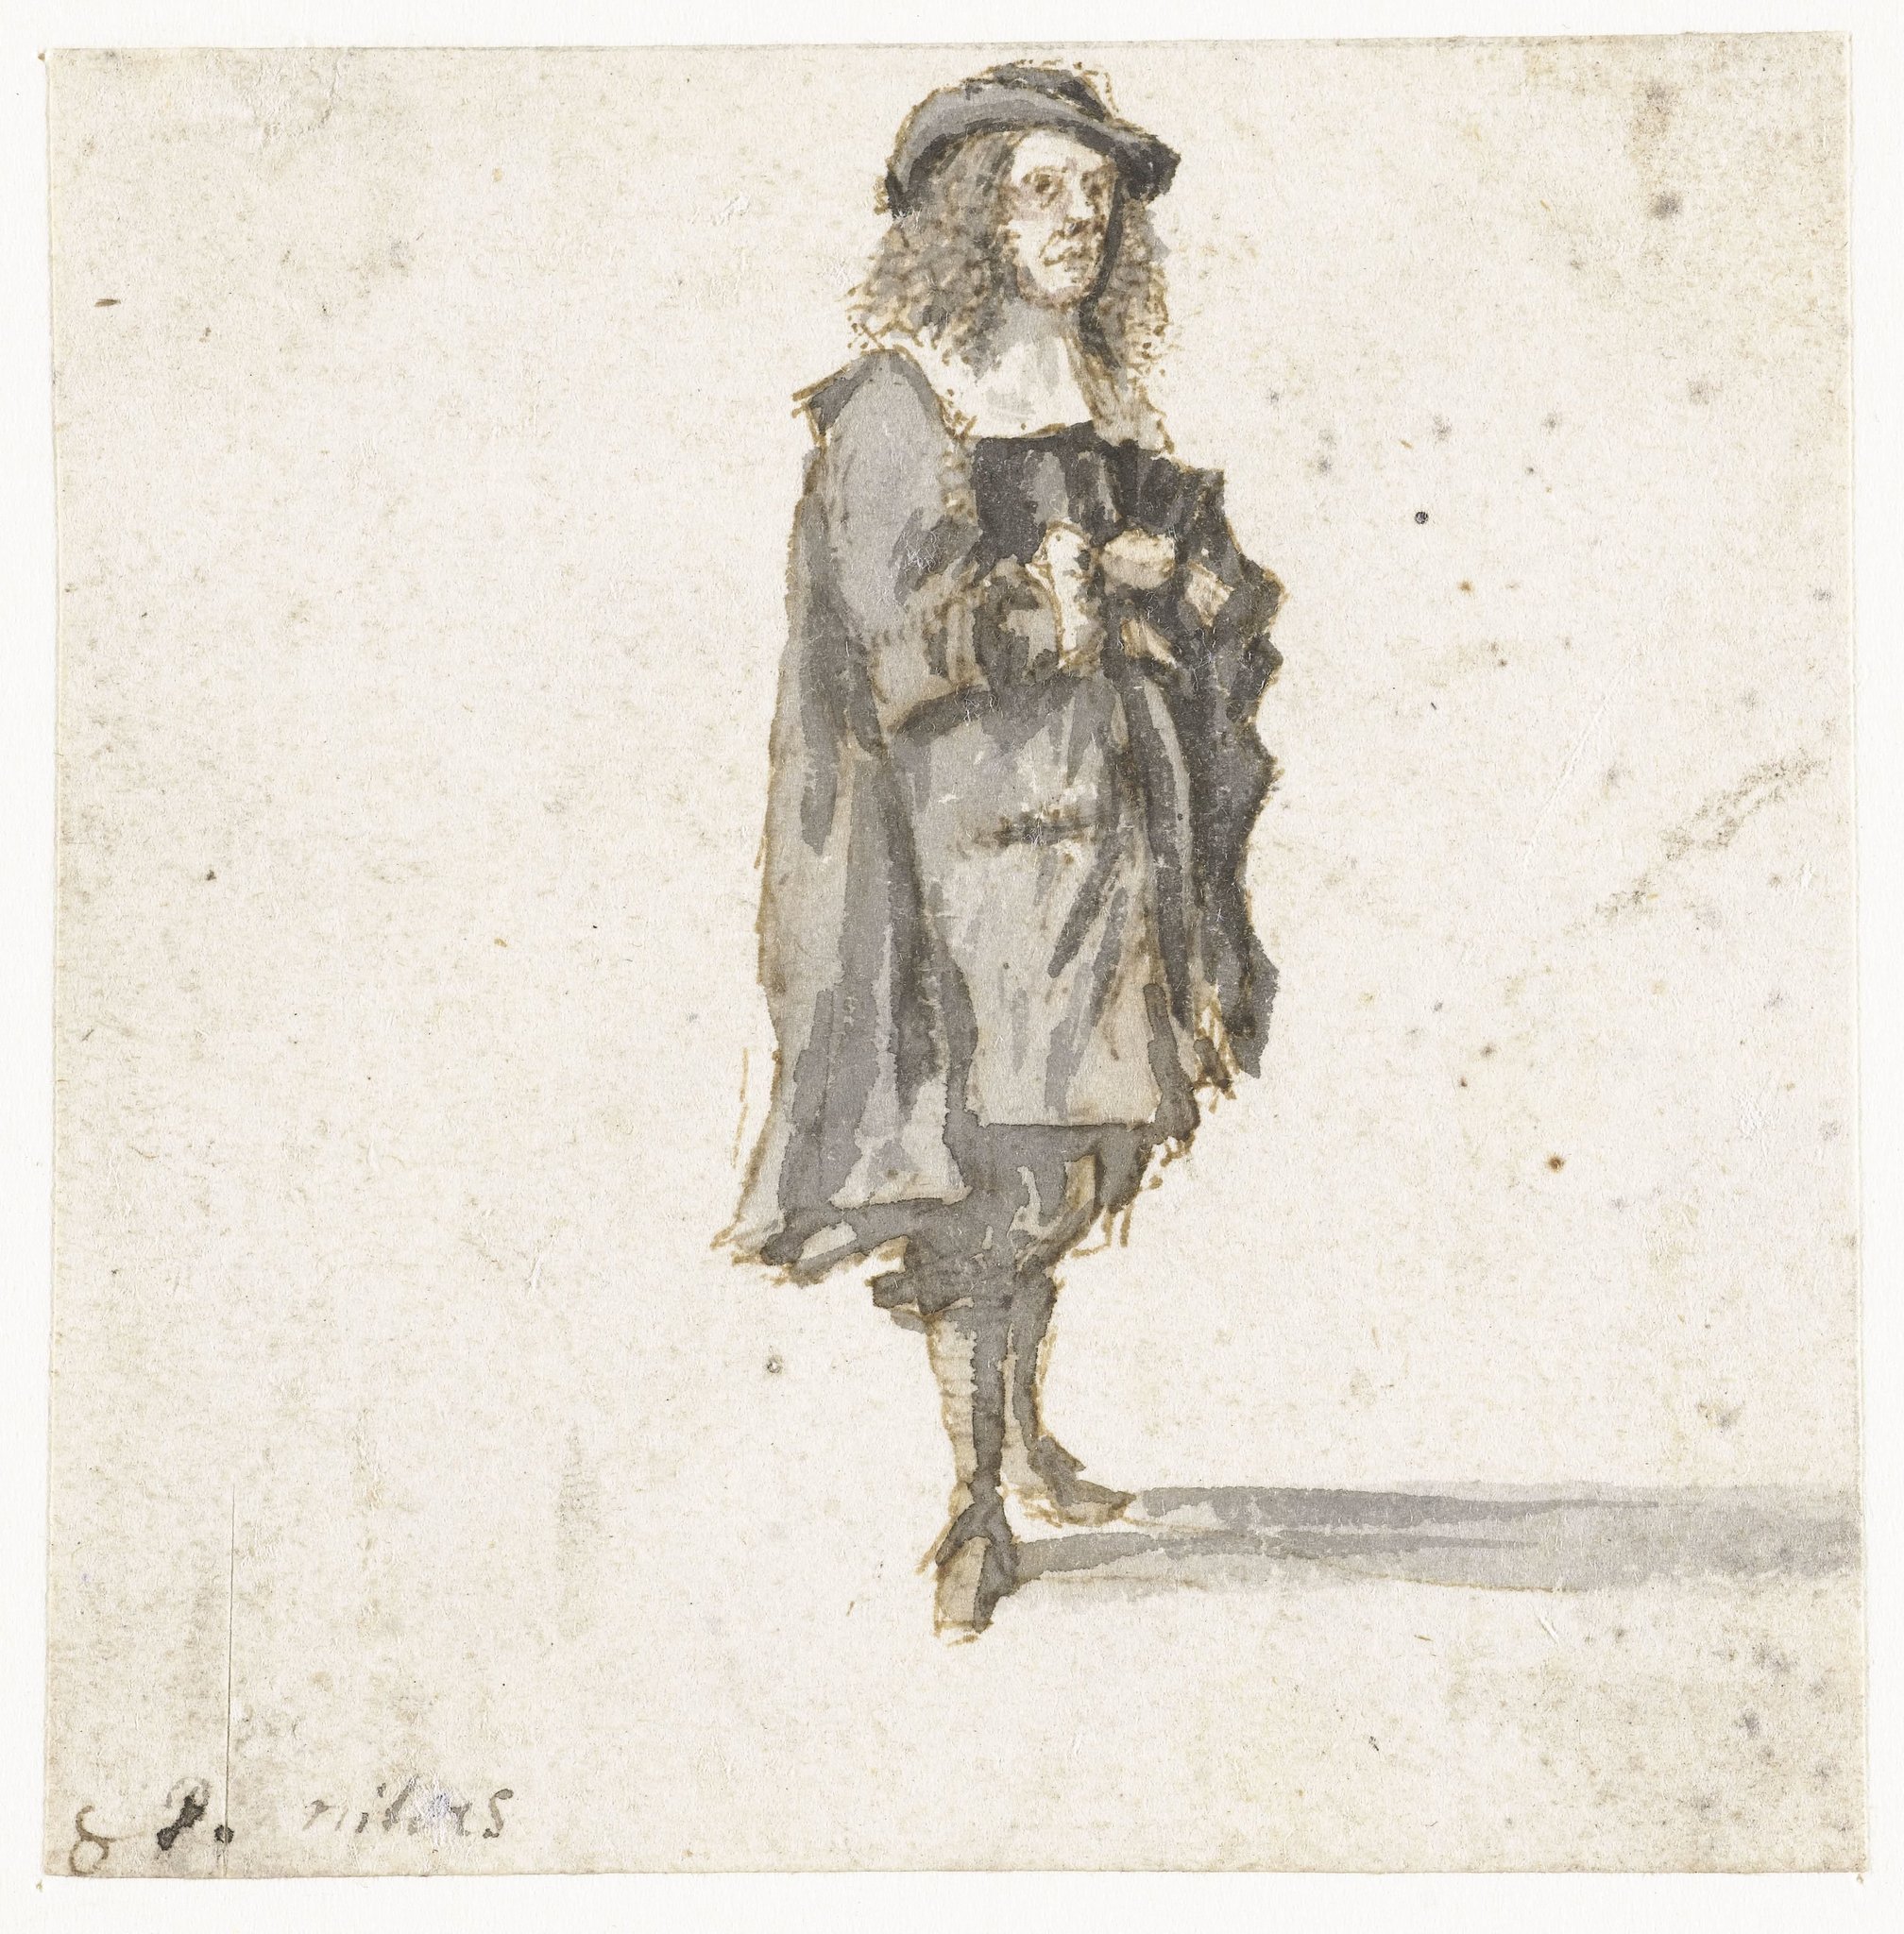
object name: drawing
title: Staande man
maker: gilles neyts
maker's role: draughtsman, print maker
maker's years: 1623-1687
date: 1633-1687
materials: paper, watercolor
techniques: brush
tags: standing figure